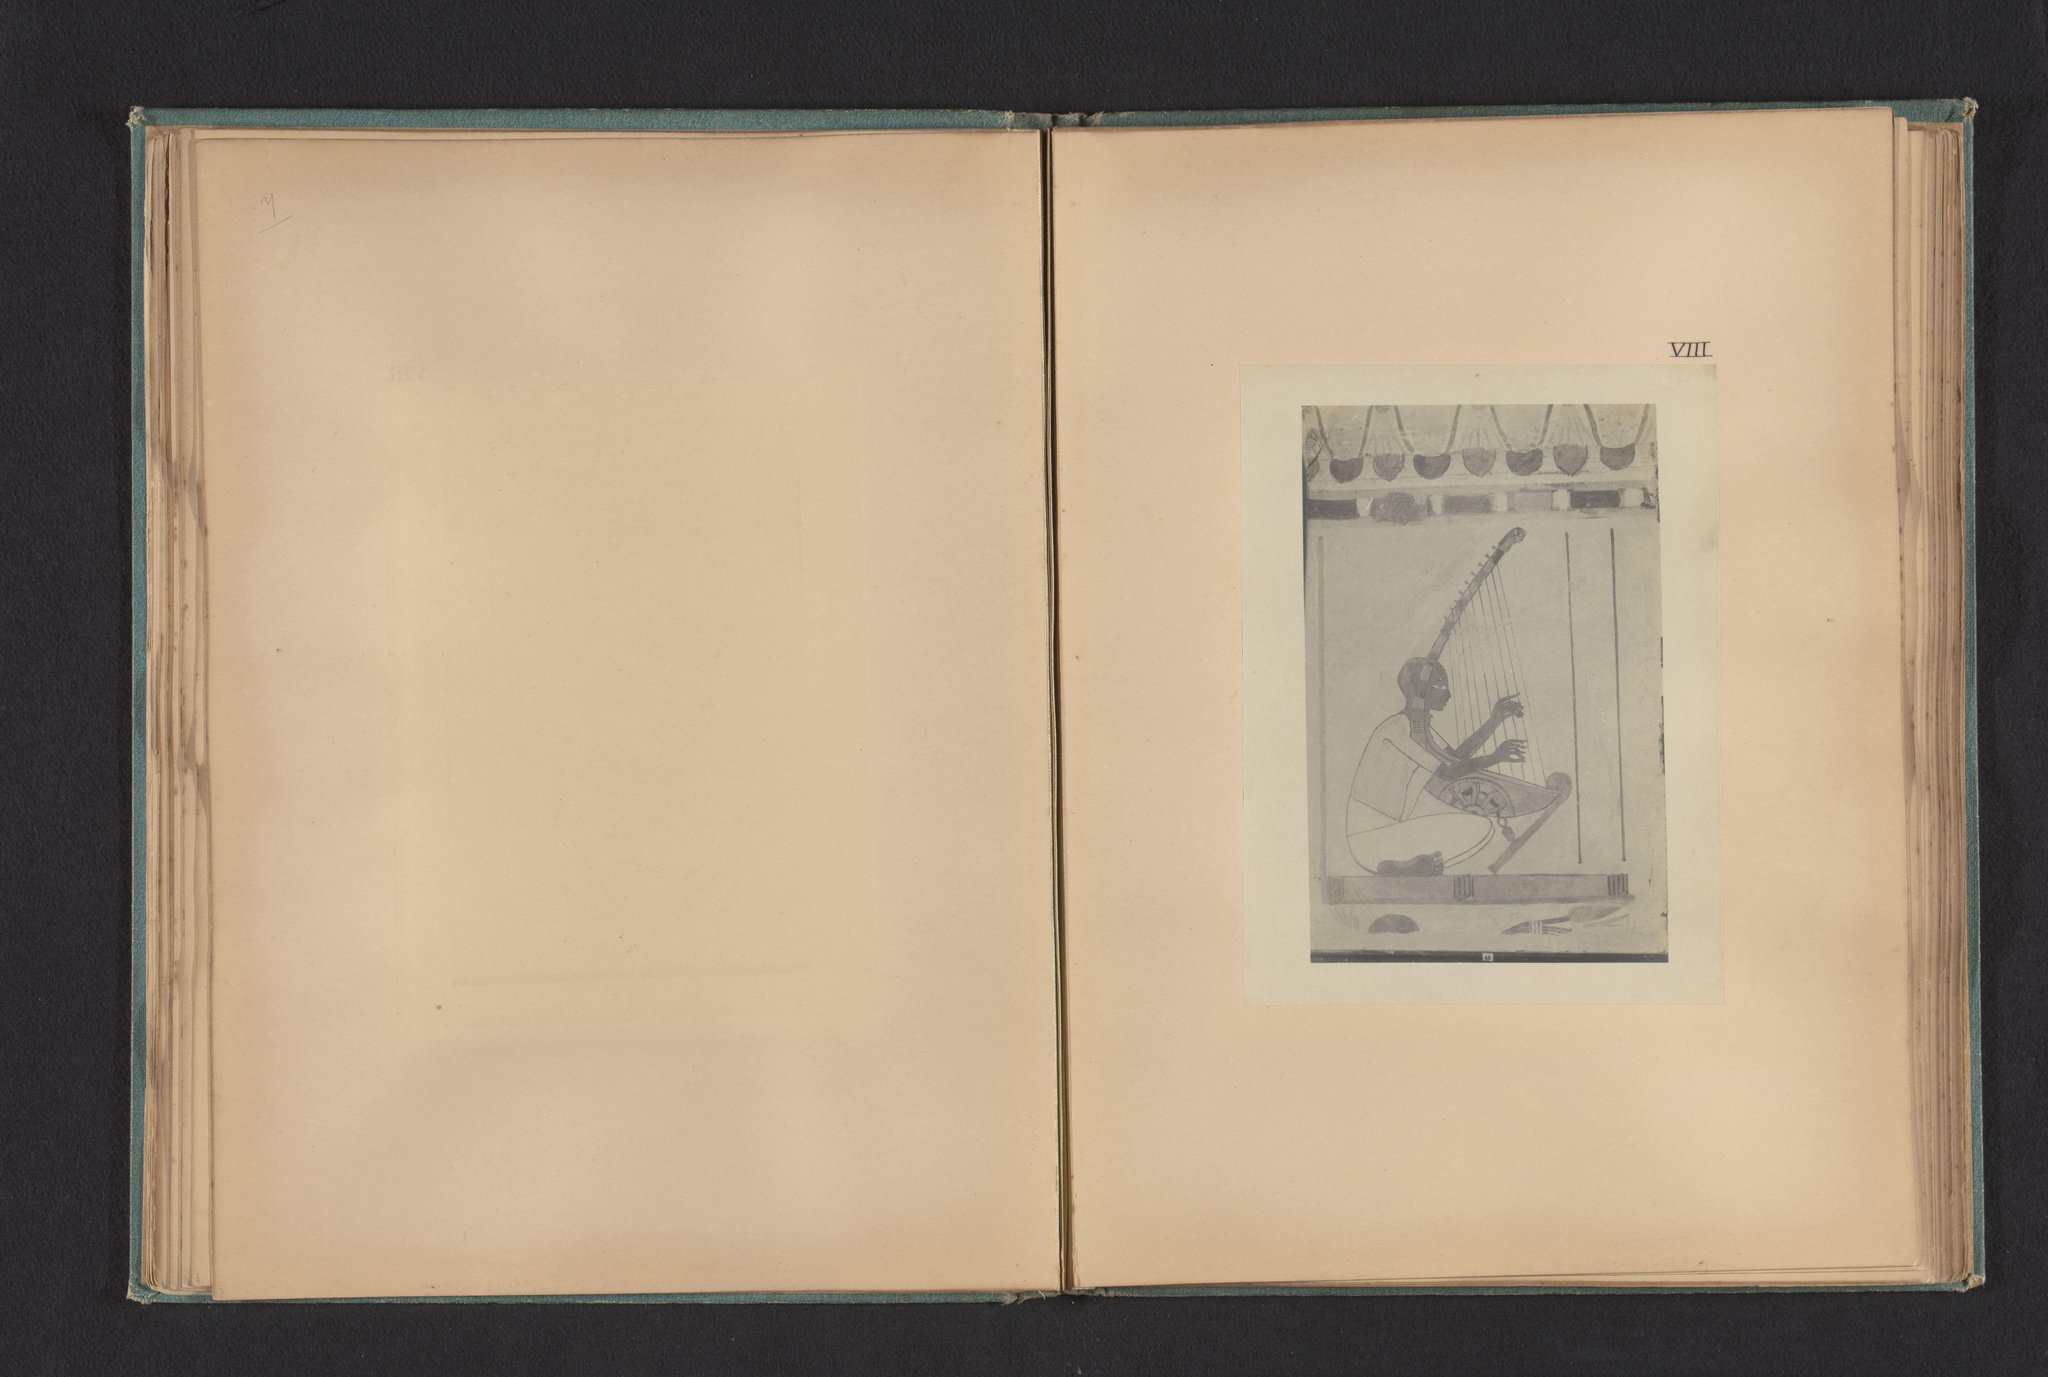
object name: photograph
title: Fragmenten van beschildering op steen uit een tombe met de afbeelding van een harpspeler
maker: Anonymous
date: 1890-1895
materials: photographic support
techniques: gelatin silver print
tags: stone ~ building material, harp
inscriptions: number: ‘VII’